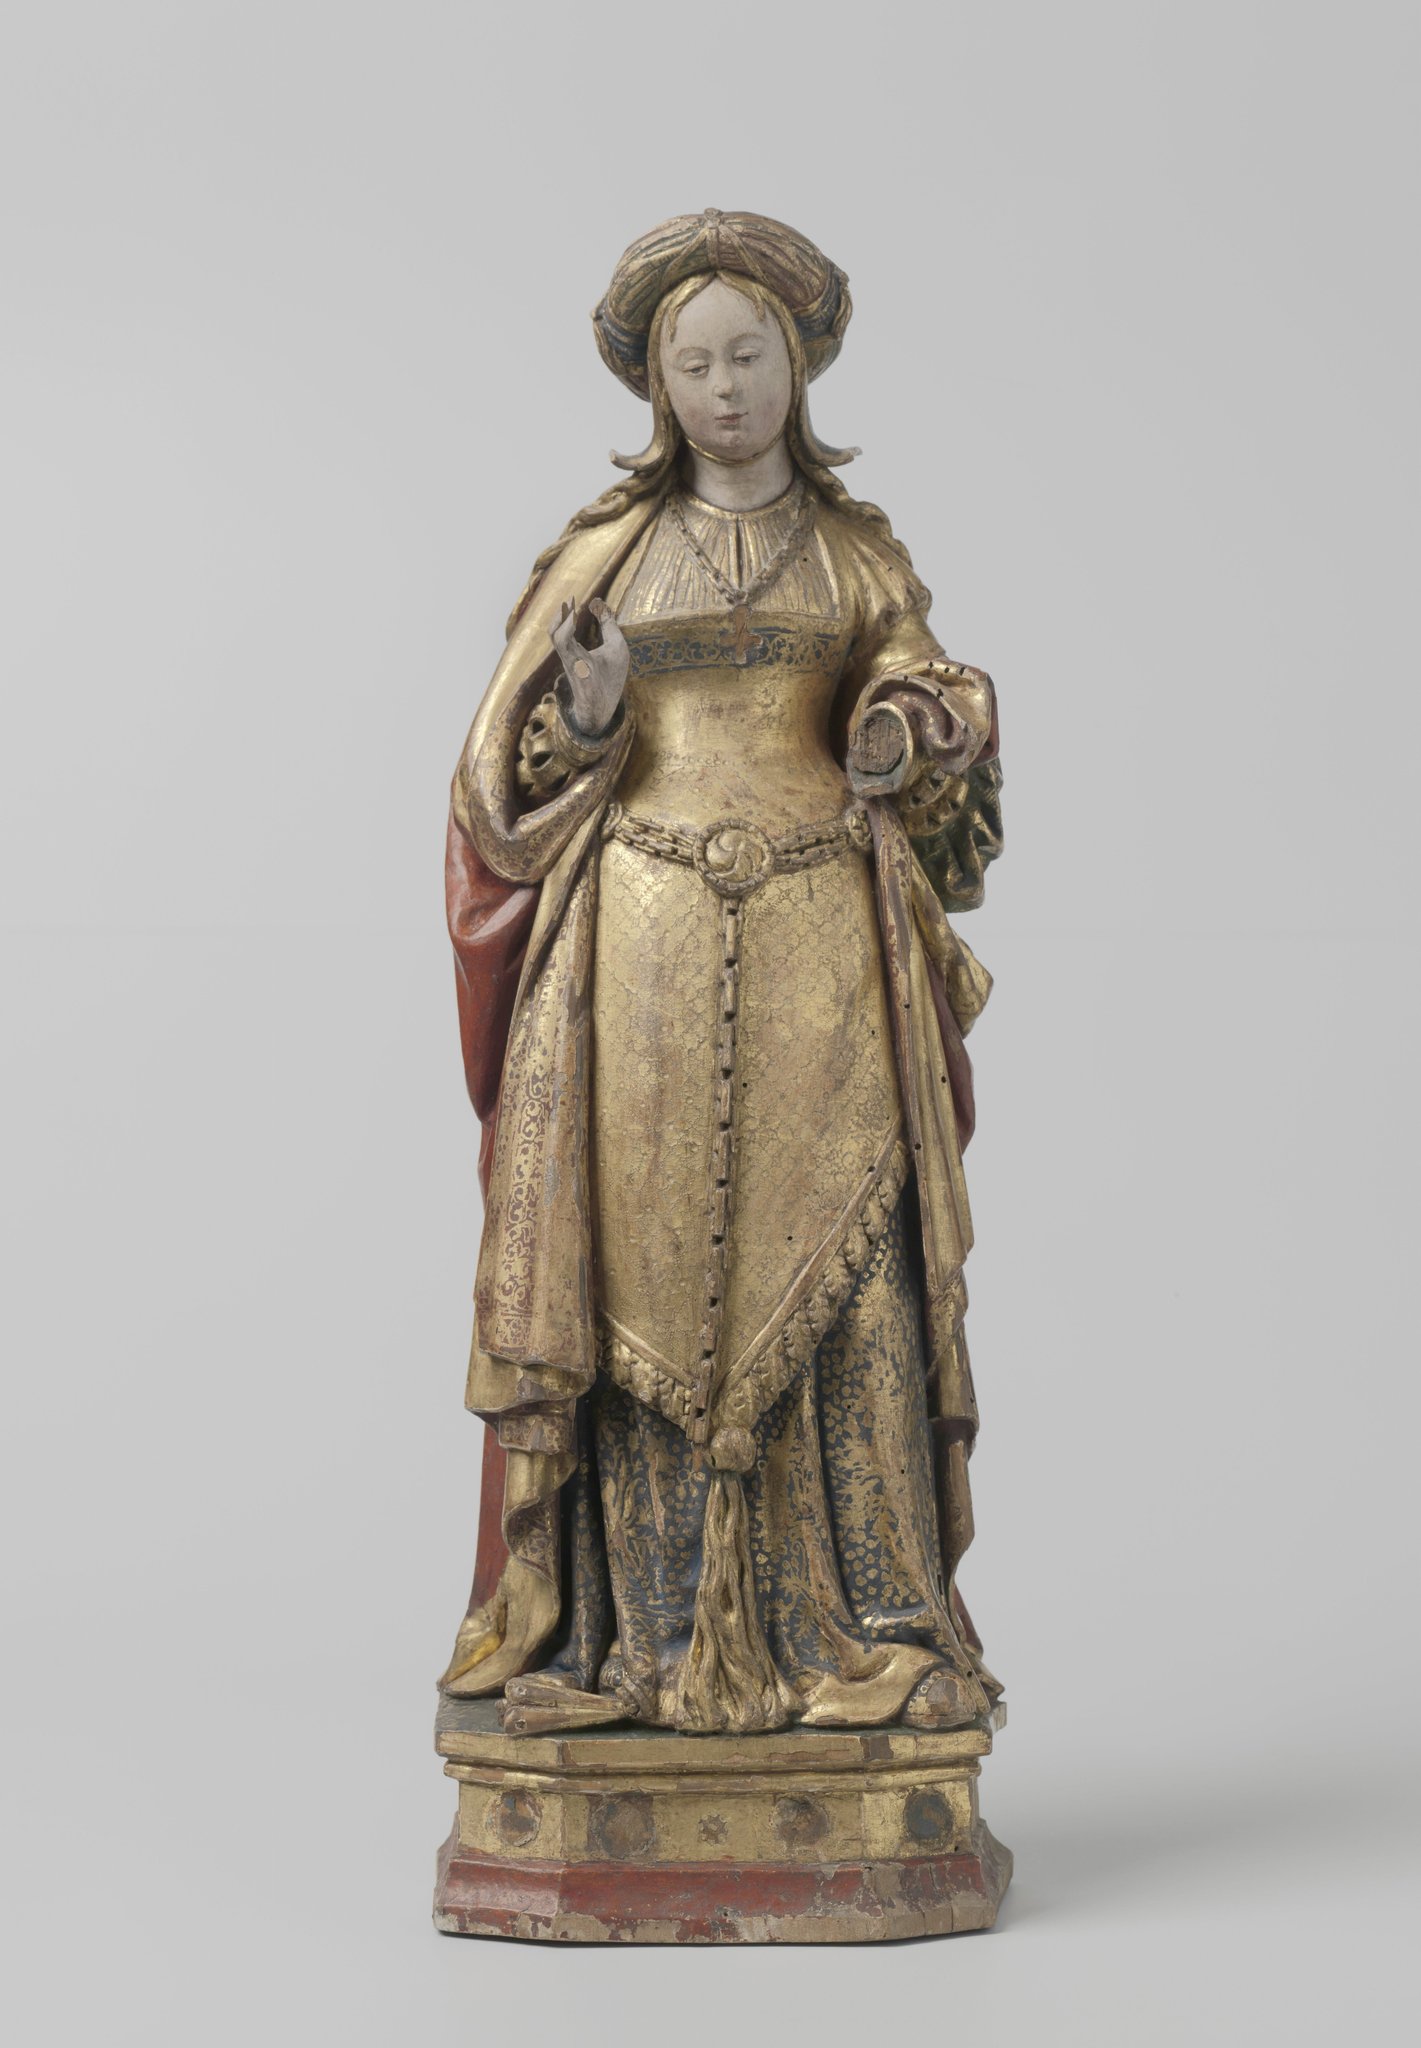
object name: sculpture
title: Female Saint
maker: Anonymous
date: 1520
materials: wood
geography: brabant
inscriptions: inscription, on the reverse at the bottom, on the hem of the mantle, in red paint: ‘C61’, label, on the underside, handwritten: ‘Eigendom v.d. heer Cuypers’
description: Female saint. Walnut with original polychromy. Mechelen (?), c. 1520. On loan from the Royal Antiquarian Society.